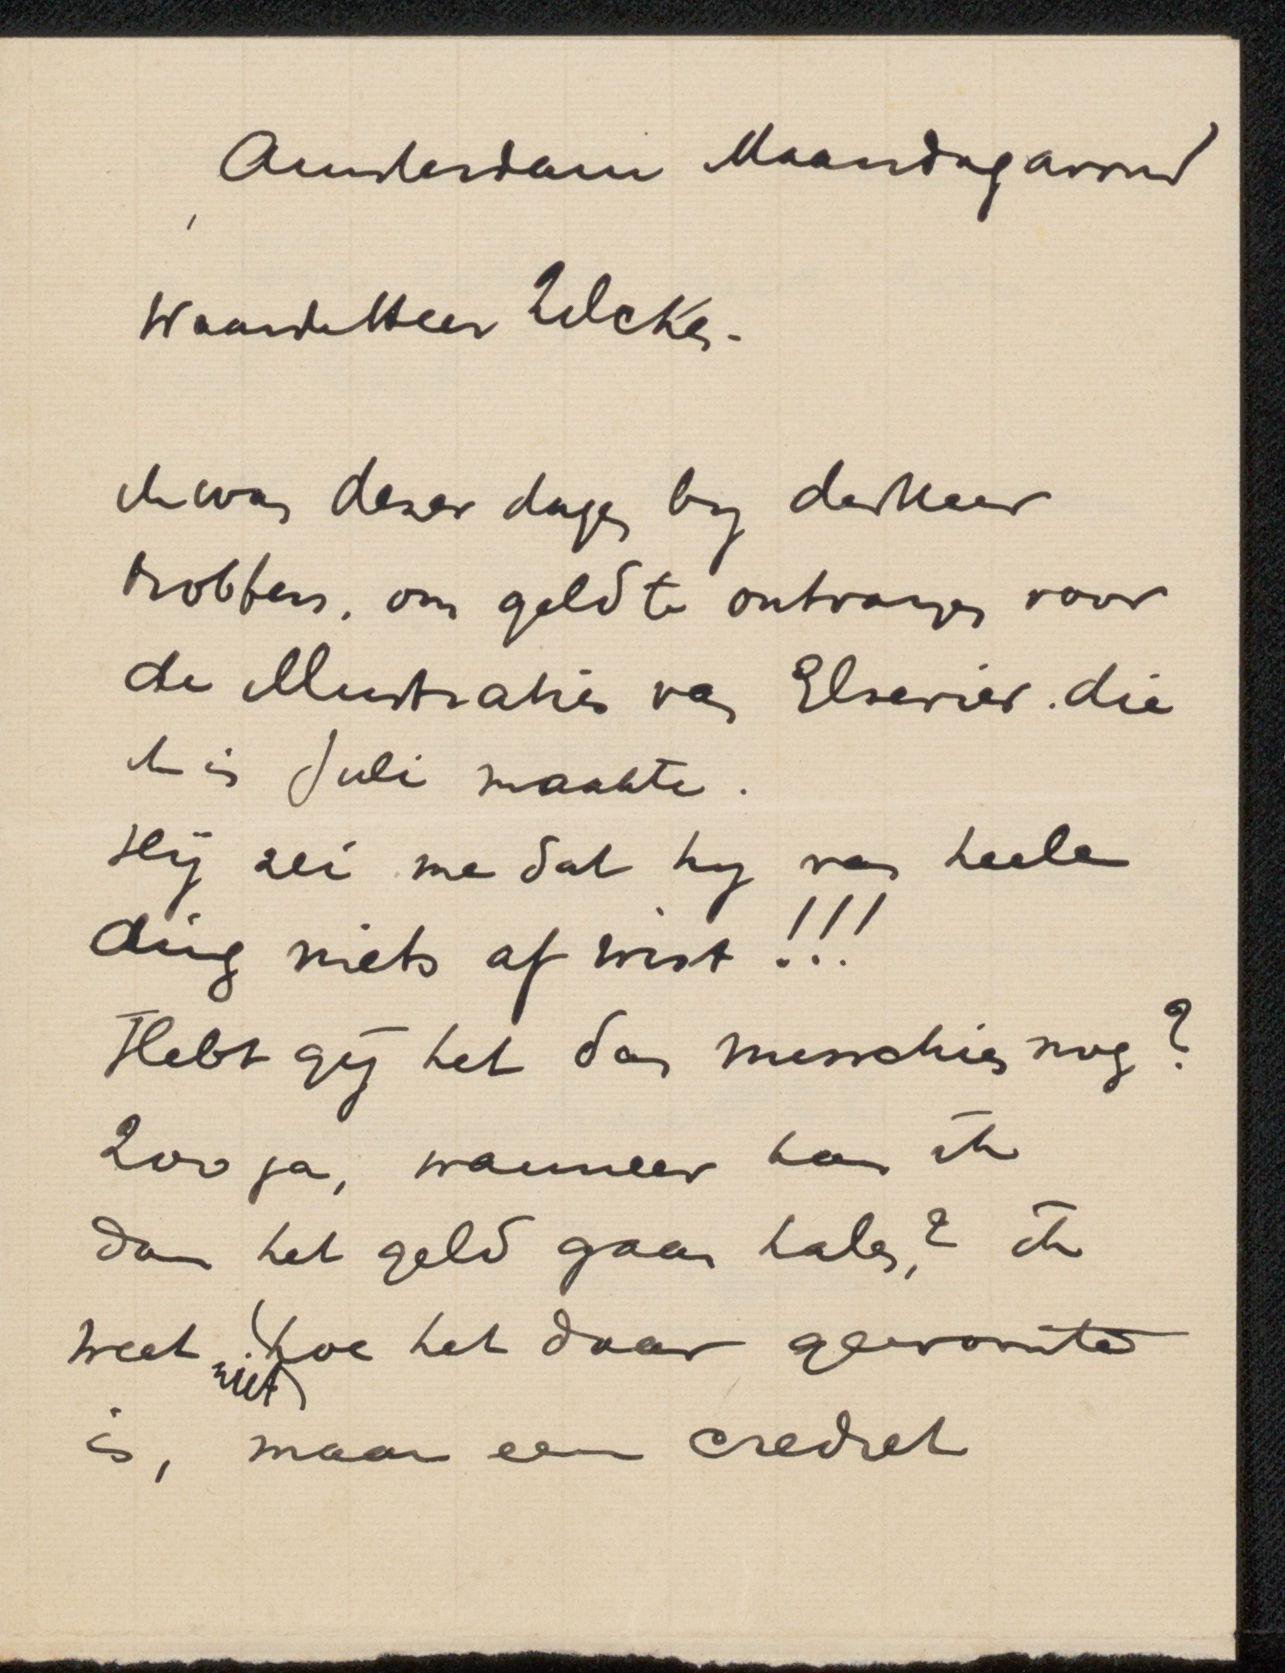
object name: letter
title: Brief aan Philip Zilcken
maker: jan de waardt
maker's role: draughtsman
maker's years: 1871-1909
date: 1881-1909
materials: ink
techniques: pen, writing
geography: amsterdam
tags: painter, philip zilcken, illustration ~ printed matter, book, money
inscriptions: collector's mark: ‘RPK’